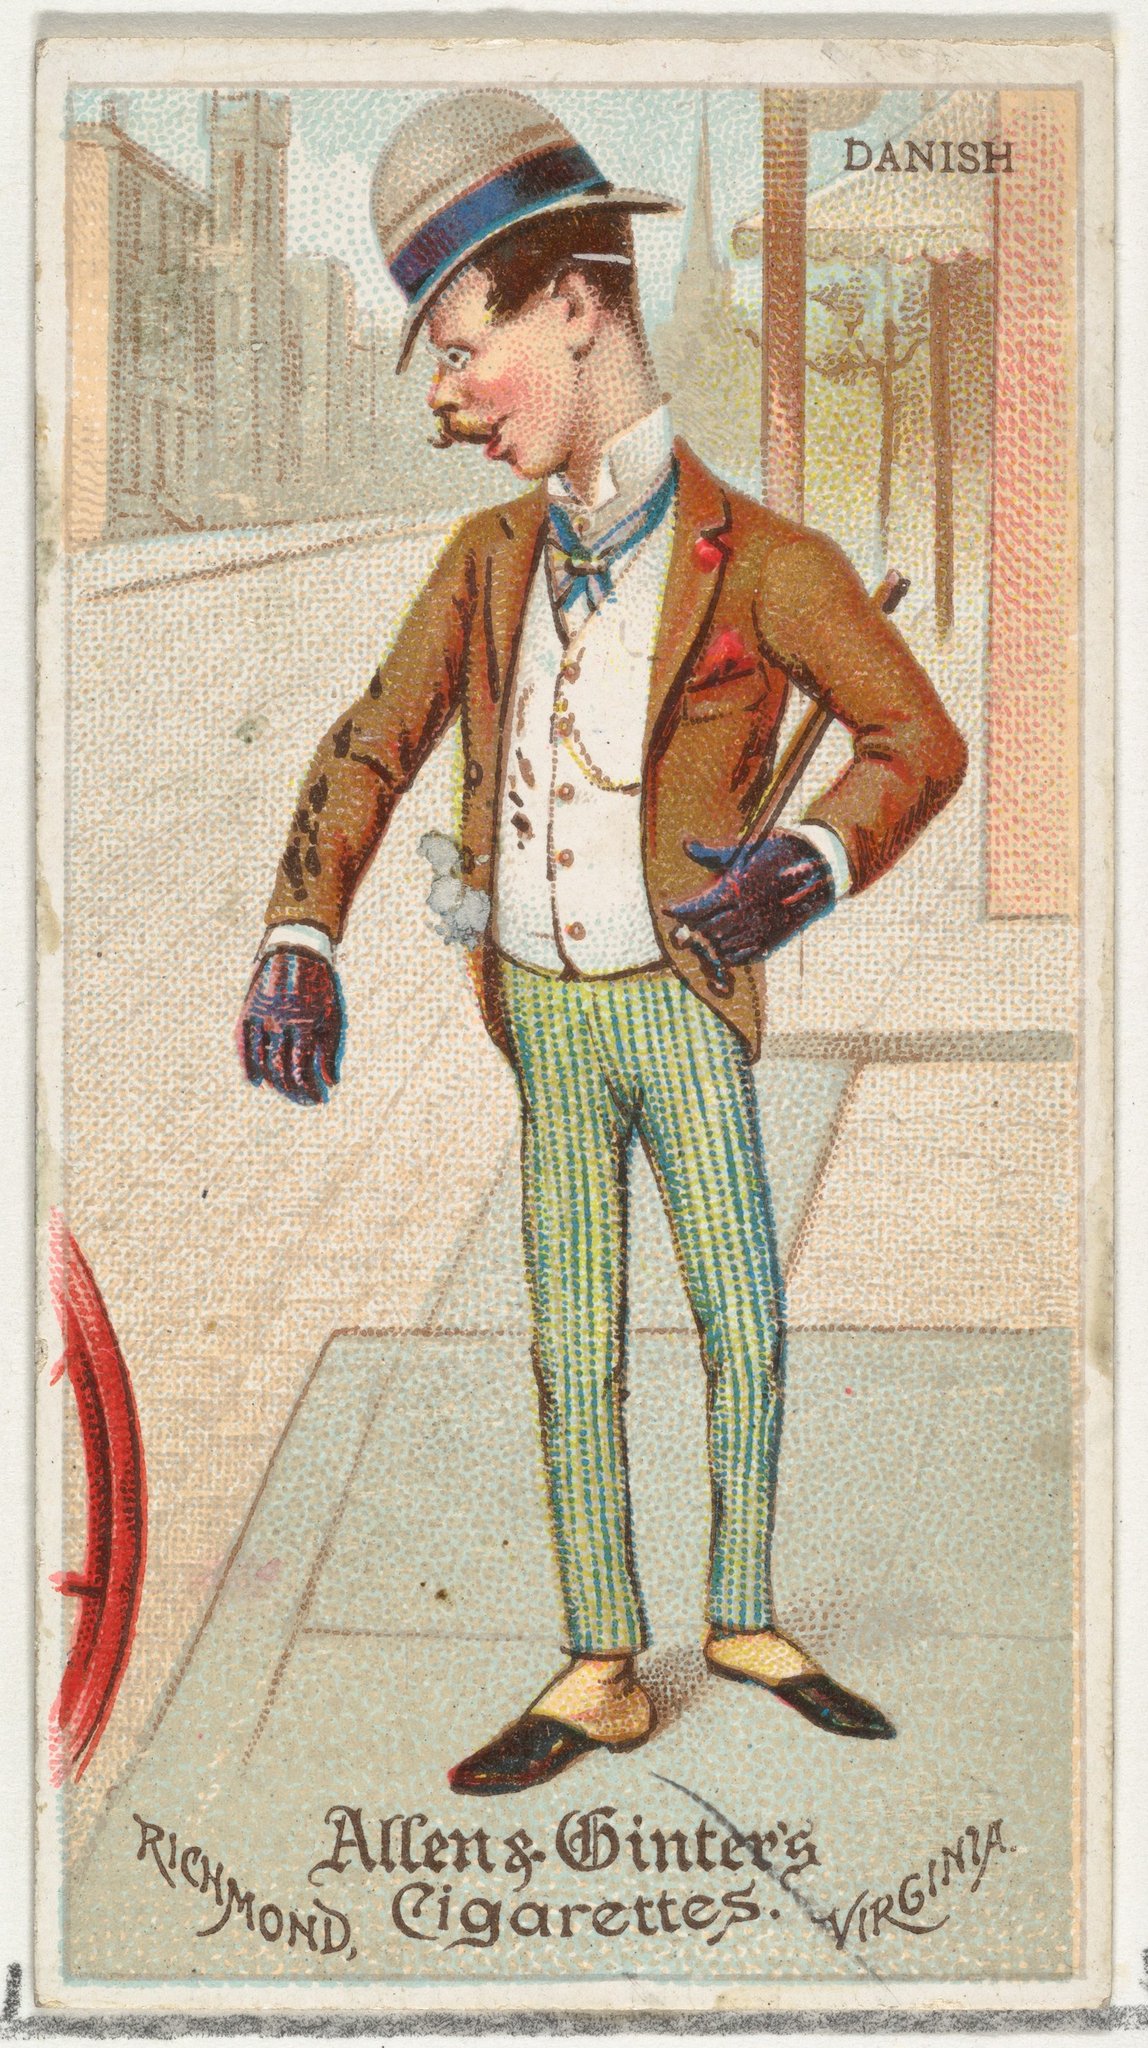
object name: print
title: Danish, from World's Dudes series (N31) for Allen & Ginter Cigarettes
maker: allen & ginter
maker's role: publisher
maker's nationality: american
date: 1888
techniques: color lithograph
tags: men,profiles